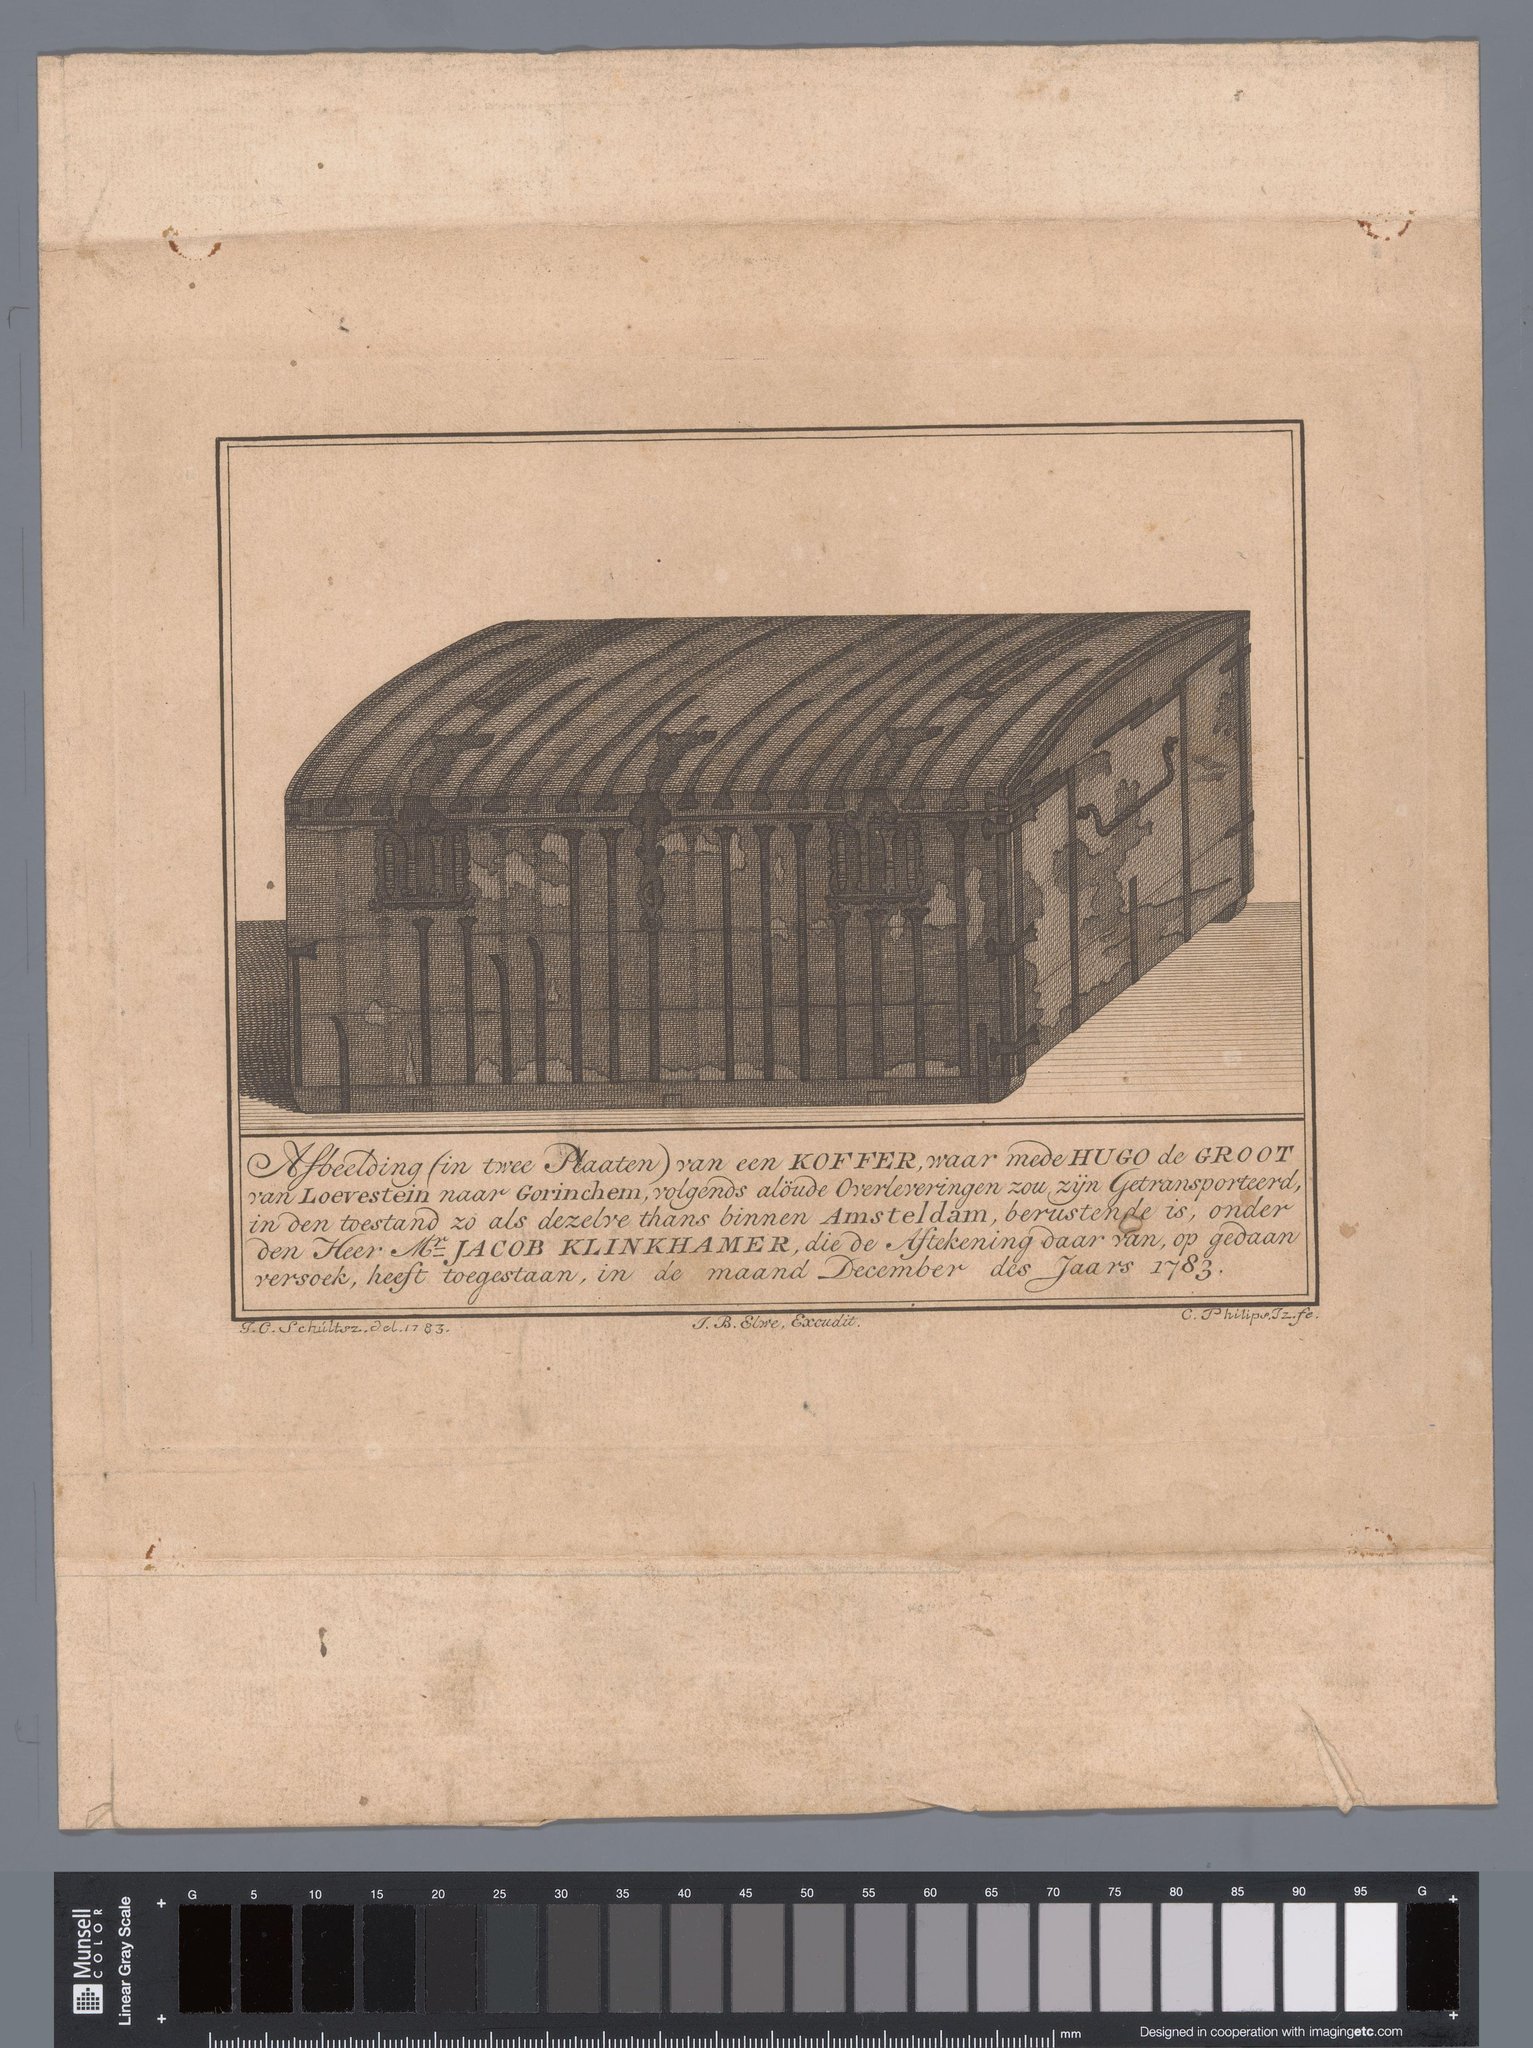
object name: print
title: Afbeelding (in twee Plaaten) van een Koffer, waar mede Hugo de Groot van Loevestein naar Gorinchem ... zou zijn Getransporteerd ...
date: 1783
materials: ink, paper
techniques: etching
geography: amsterdam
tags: delft, hugo de groot, hoorn (north holland), trunk, suit-case, loevestein castle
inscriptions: caption: ‘Afbeelding (in twee Plaaten) van een KOFFER, waar mede HUGO de GROOT van Loevestein naar Gorinchem, volgens alöude Overleveringen zou zijn Getransporteerd, in den toestand zo als dezelve thans binnen Amsteldam, berustende is, onder den Heer Mr JACOB KLINKHAMER, die de Aftekening daar van, op gedaan versoek, heeft toegestaan, in de maand December des Jaars 1783.’, signature: ‘J.C. Schultsz’, signature: ‘J.B. Elwe, Excudit.’, date: ‘del. 1783.’, signature: ‘C. Philips, Jz. fe.’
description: Afbeelding van een gesloten koffer binnen kader waaronder opschrift binnen kader. Volgens het onderschrift is dit de koffer waarin Hugo de Groot van Loevestein naar Gorinchem is gevlucht. De koffer bevond zich ten tijde van afbeelden in december 1783 in het bezit van de heer Jacob Klinkhamer te Amsterdam.